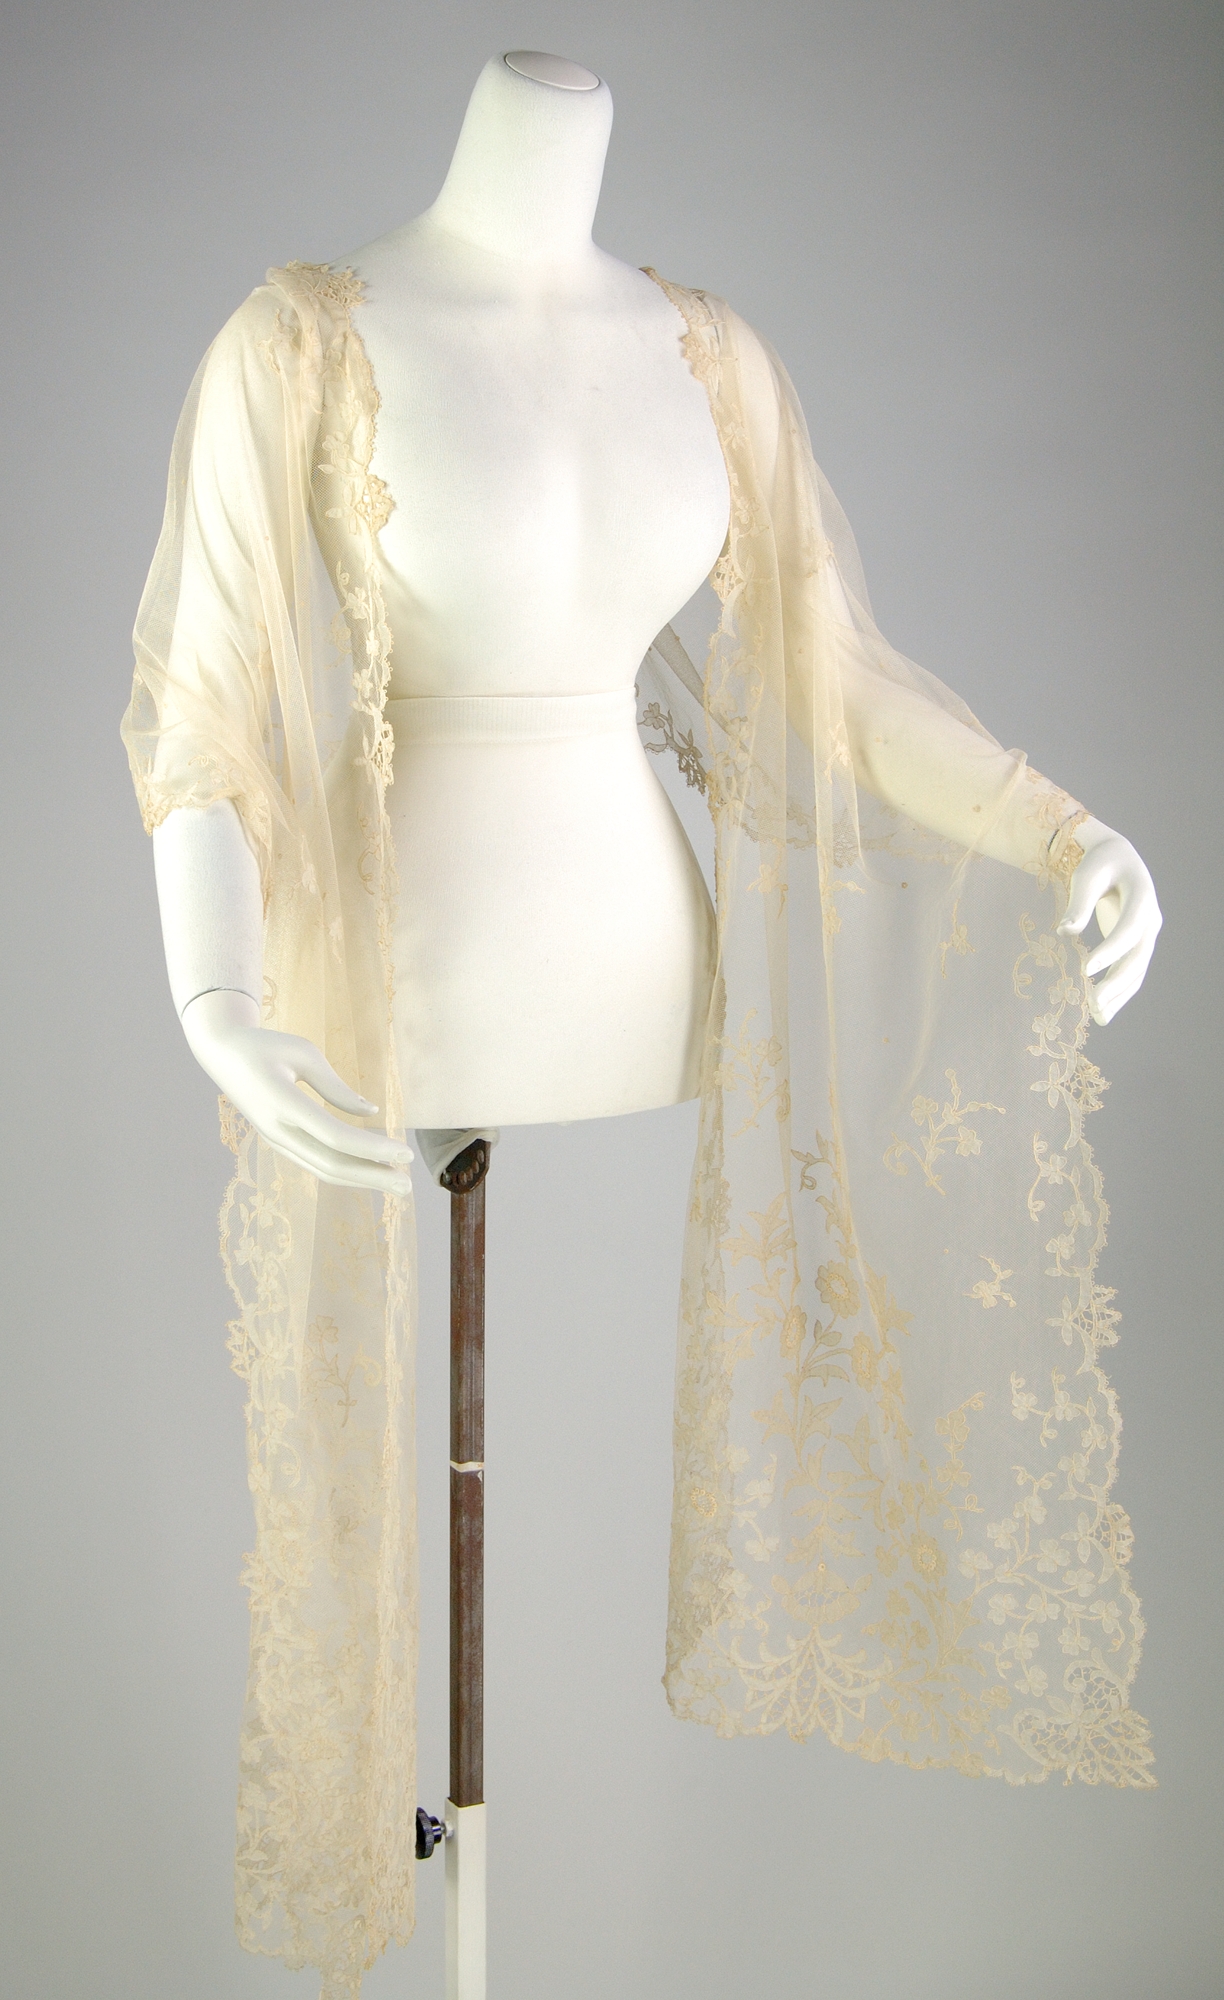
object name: stole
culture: irish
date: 1834-1866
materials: cotton